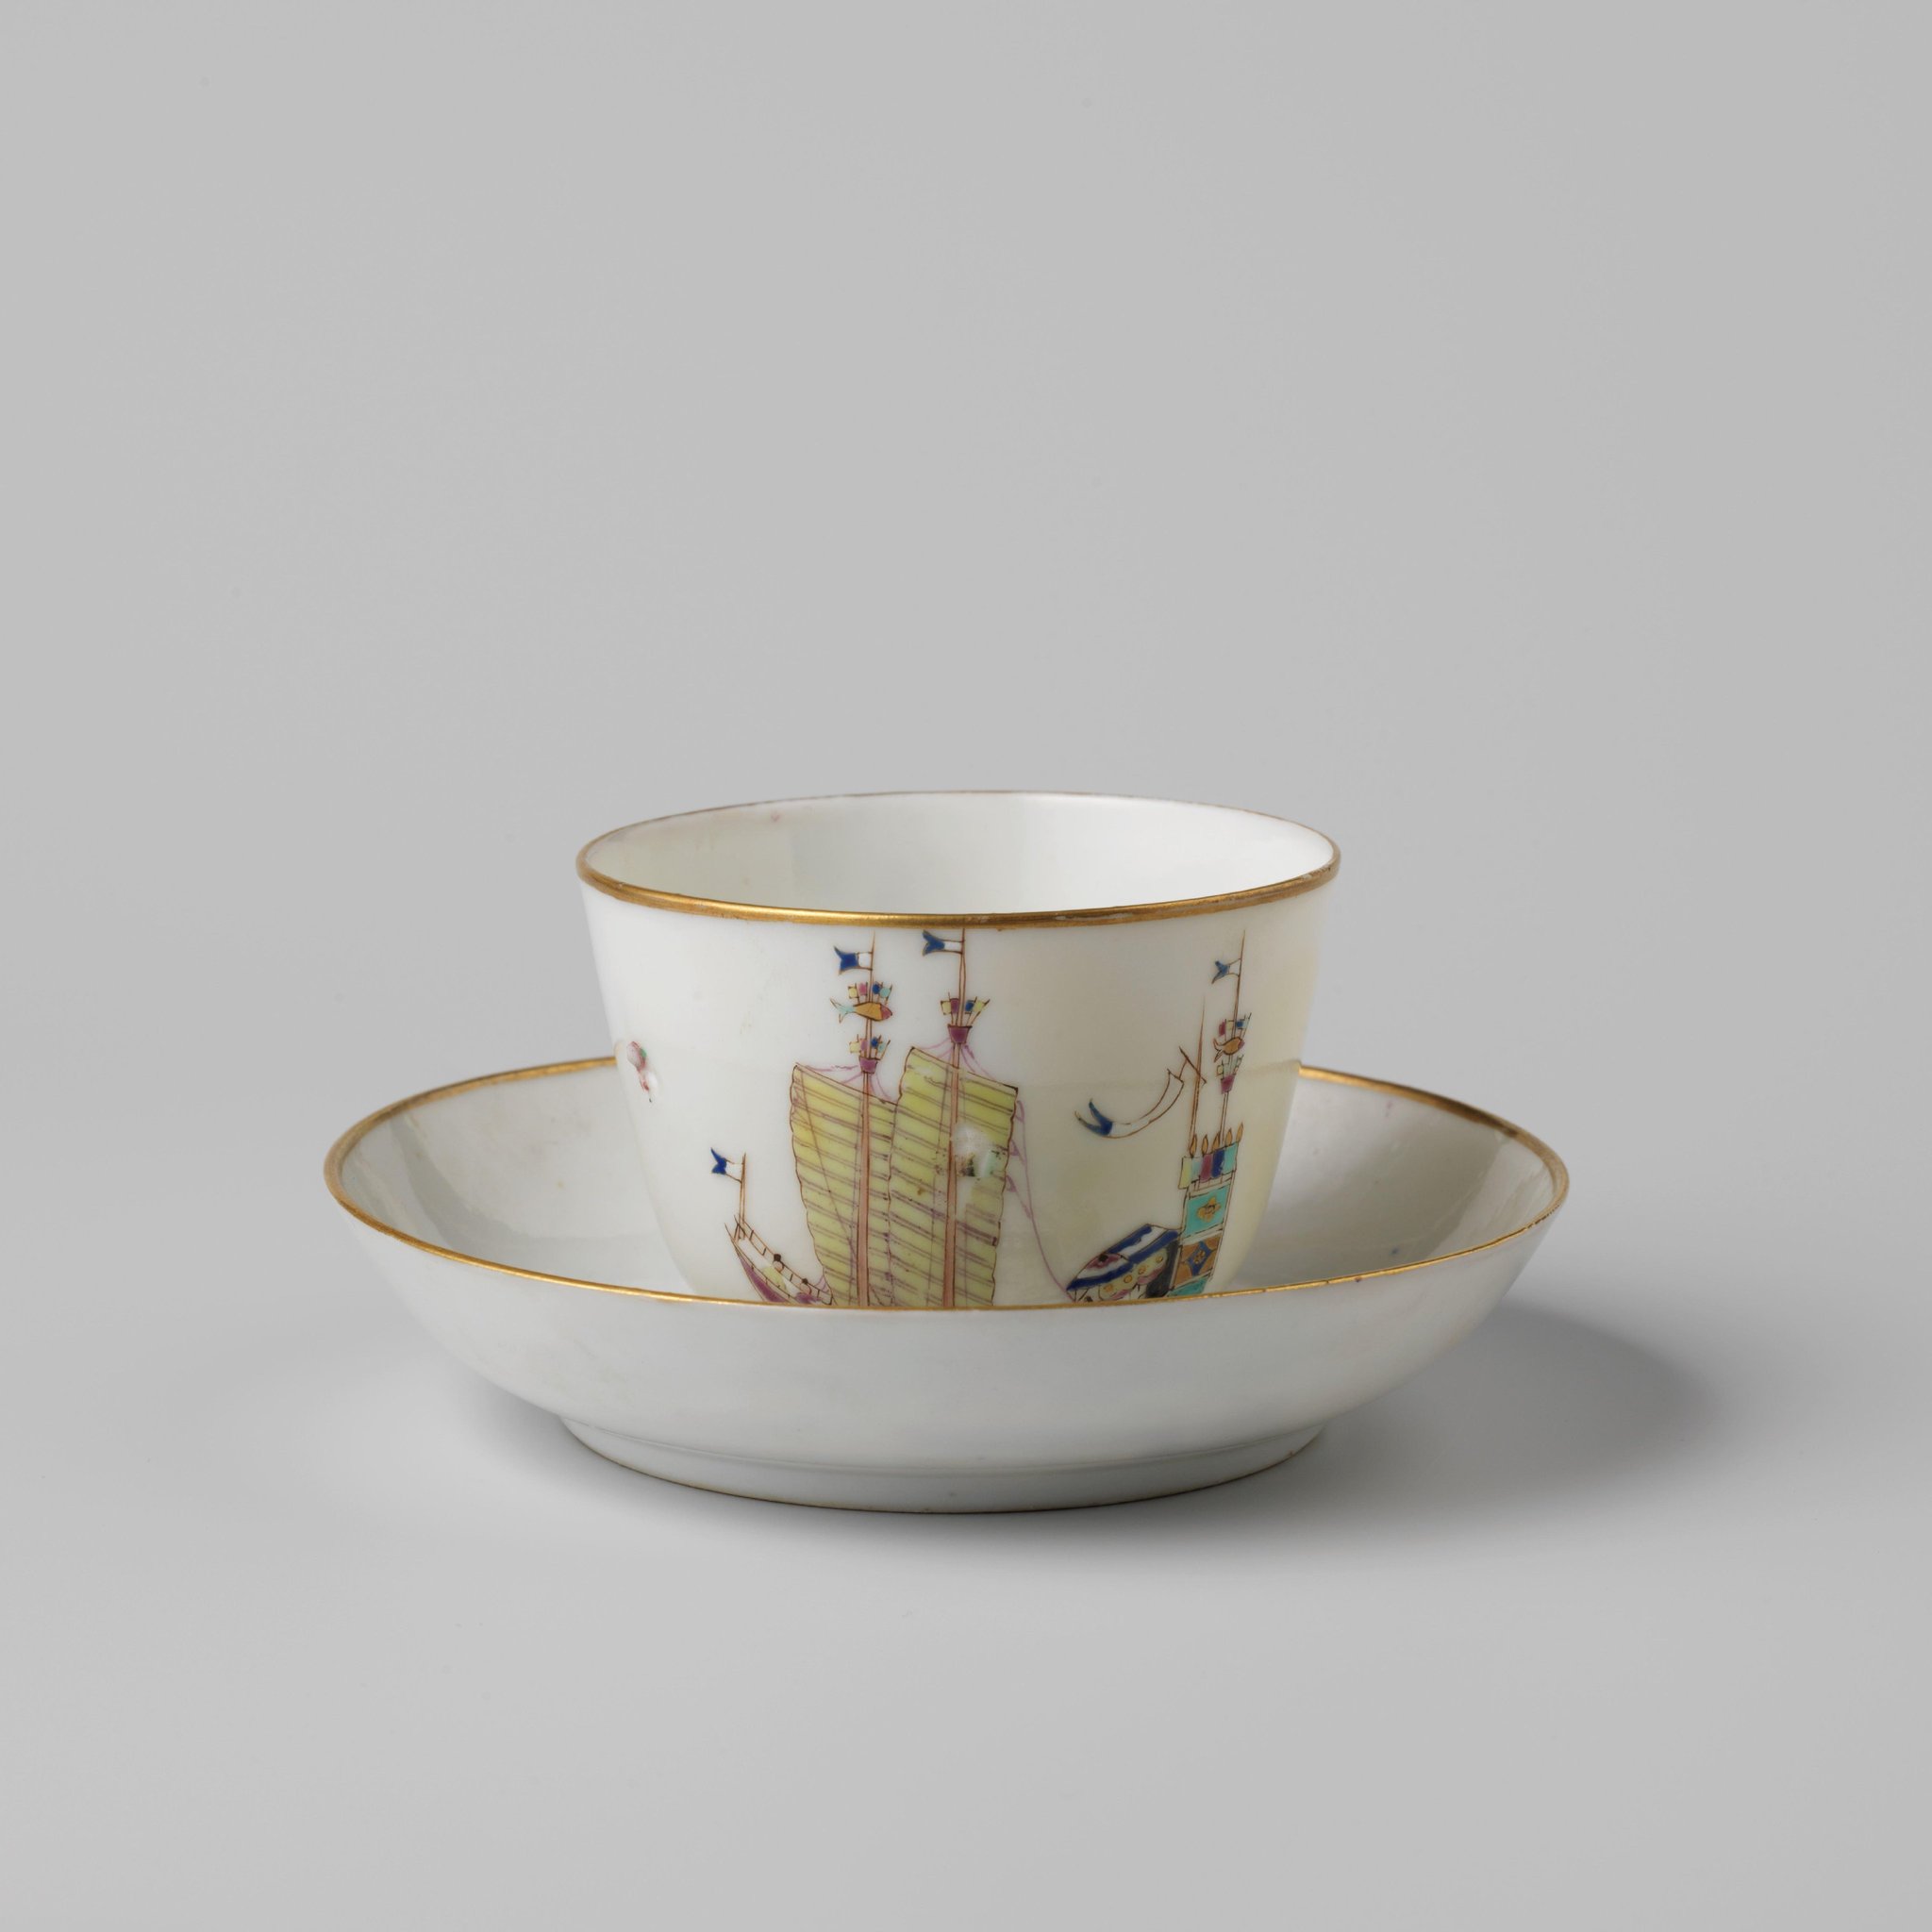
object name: kop en schotel, kop en schotel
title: Cup and saucer with a Chinese junk and the arms of Amsterdam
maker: Anonymous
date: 1800-1899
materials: glaze, gold, paint, porcelain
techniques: firing, gilding, turning, vitrification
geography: china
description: Kop en schotel van porselein, beschilderd op het glazuur in blauw, rood, roze, groen, geel, zwart en goud. Op de voorzijde van de schotel een Chinese jonk met bemanning op de golven, daarboven het wapen van Amsterdam. De kop met dezelfde decoratie. Een barst in de wand van de schotel. Wapenporselein.